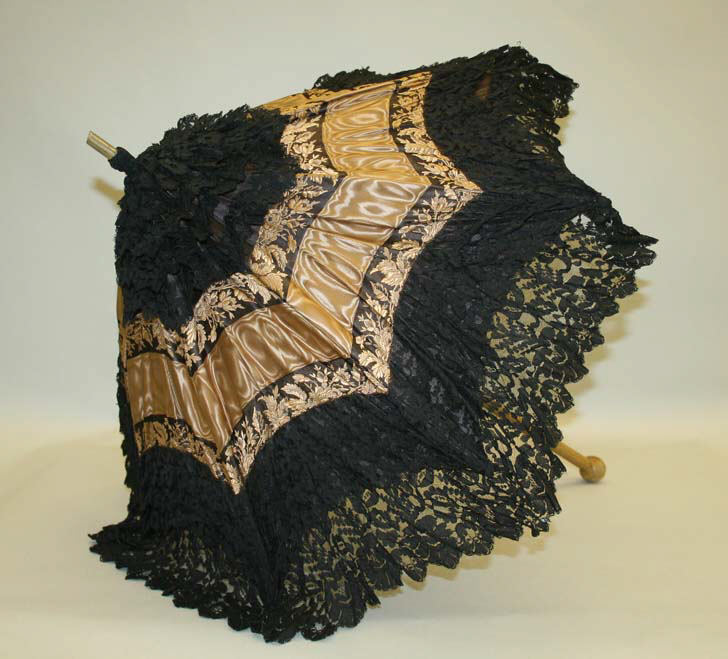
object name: parasol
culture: american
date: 1890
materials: silk